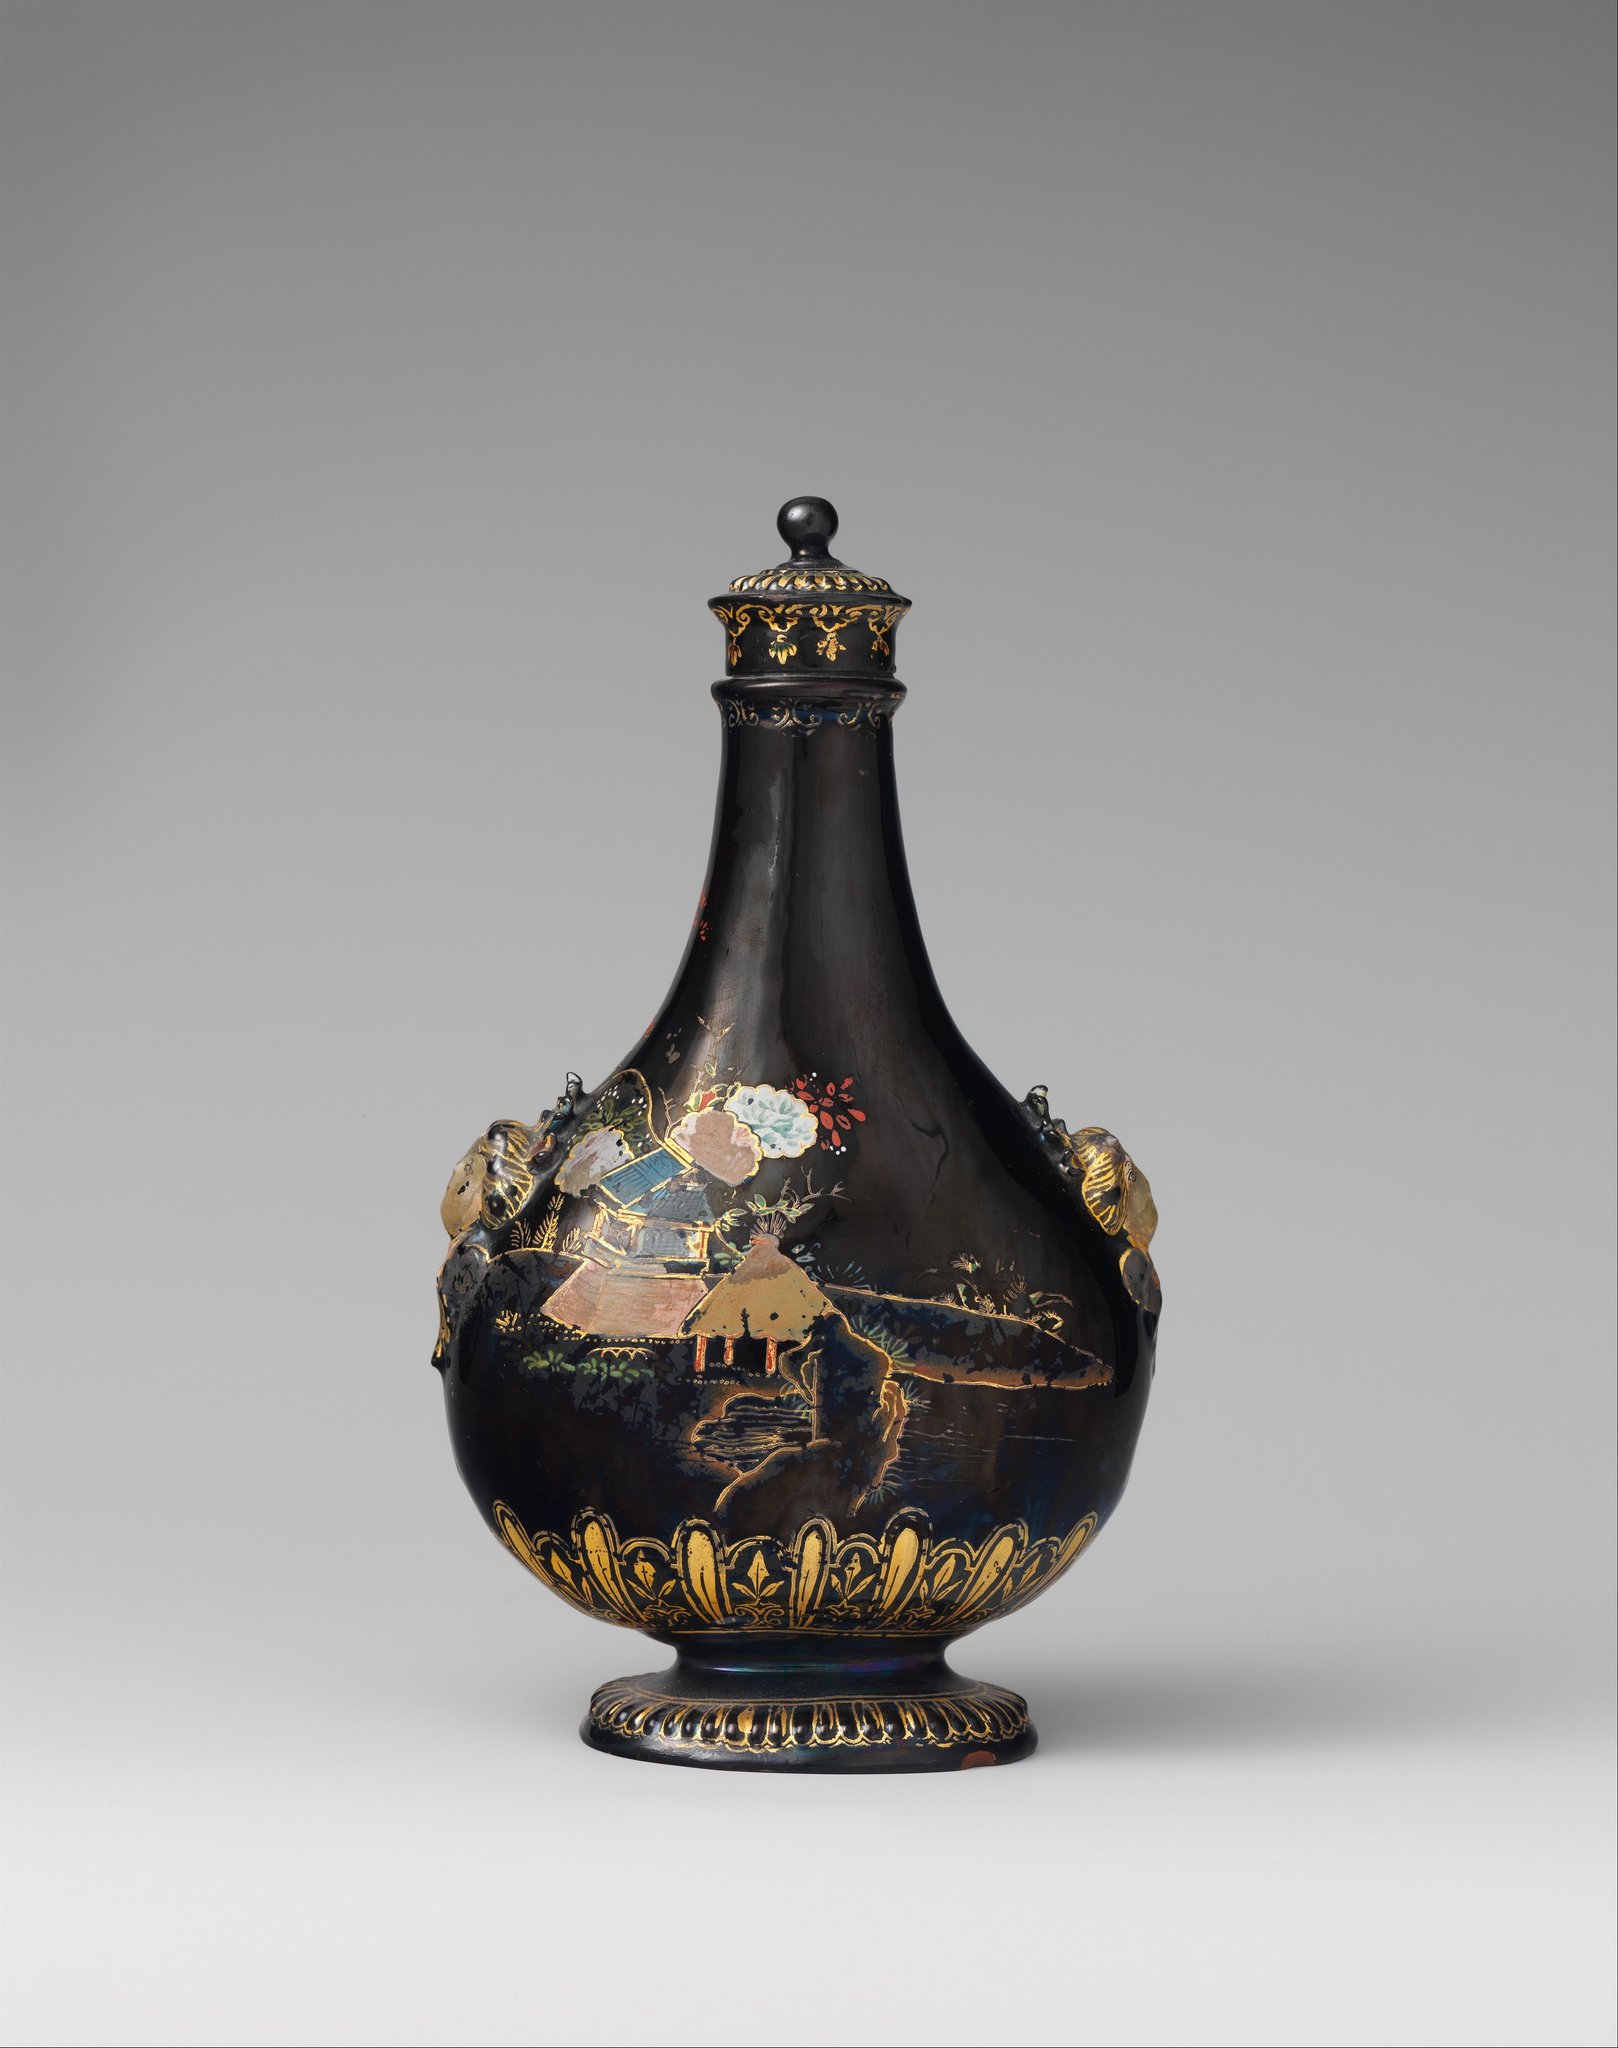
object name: pilgrim bottle with cover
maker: meissen manufactory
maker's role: manufactory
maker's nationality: german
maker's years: 1710-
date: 1710-1715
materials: glaze, stoneware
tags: cranes,chinoiserie